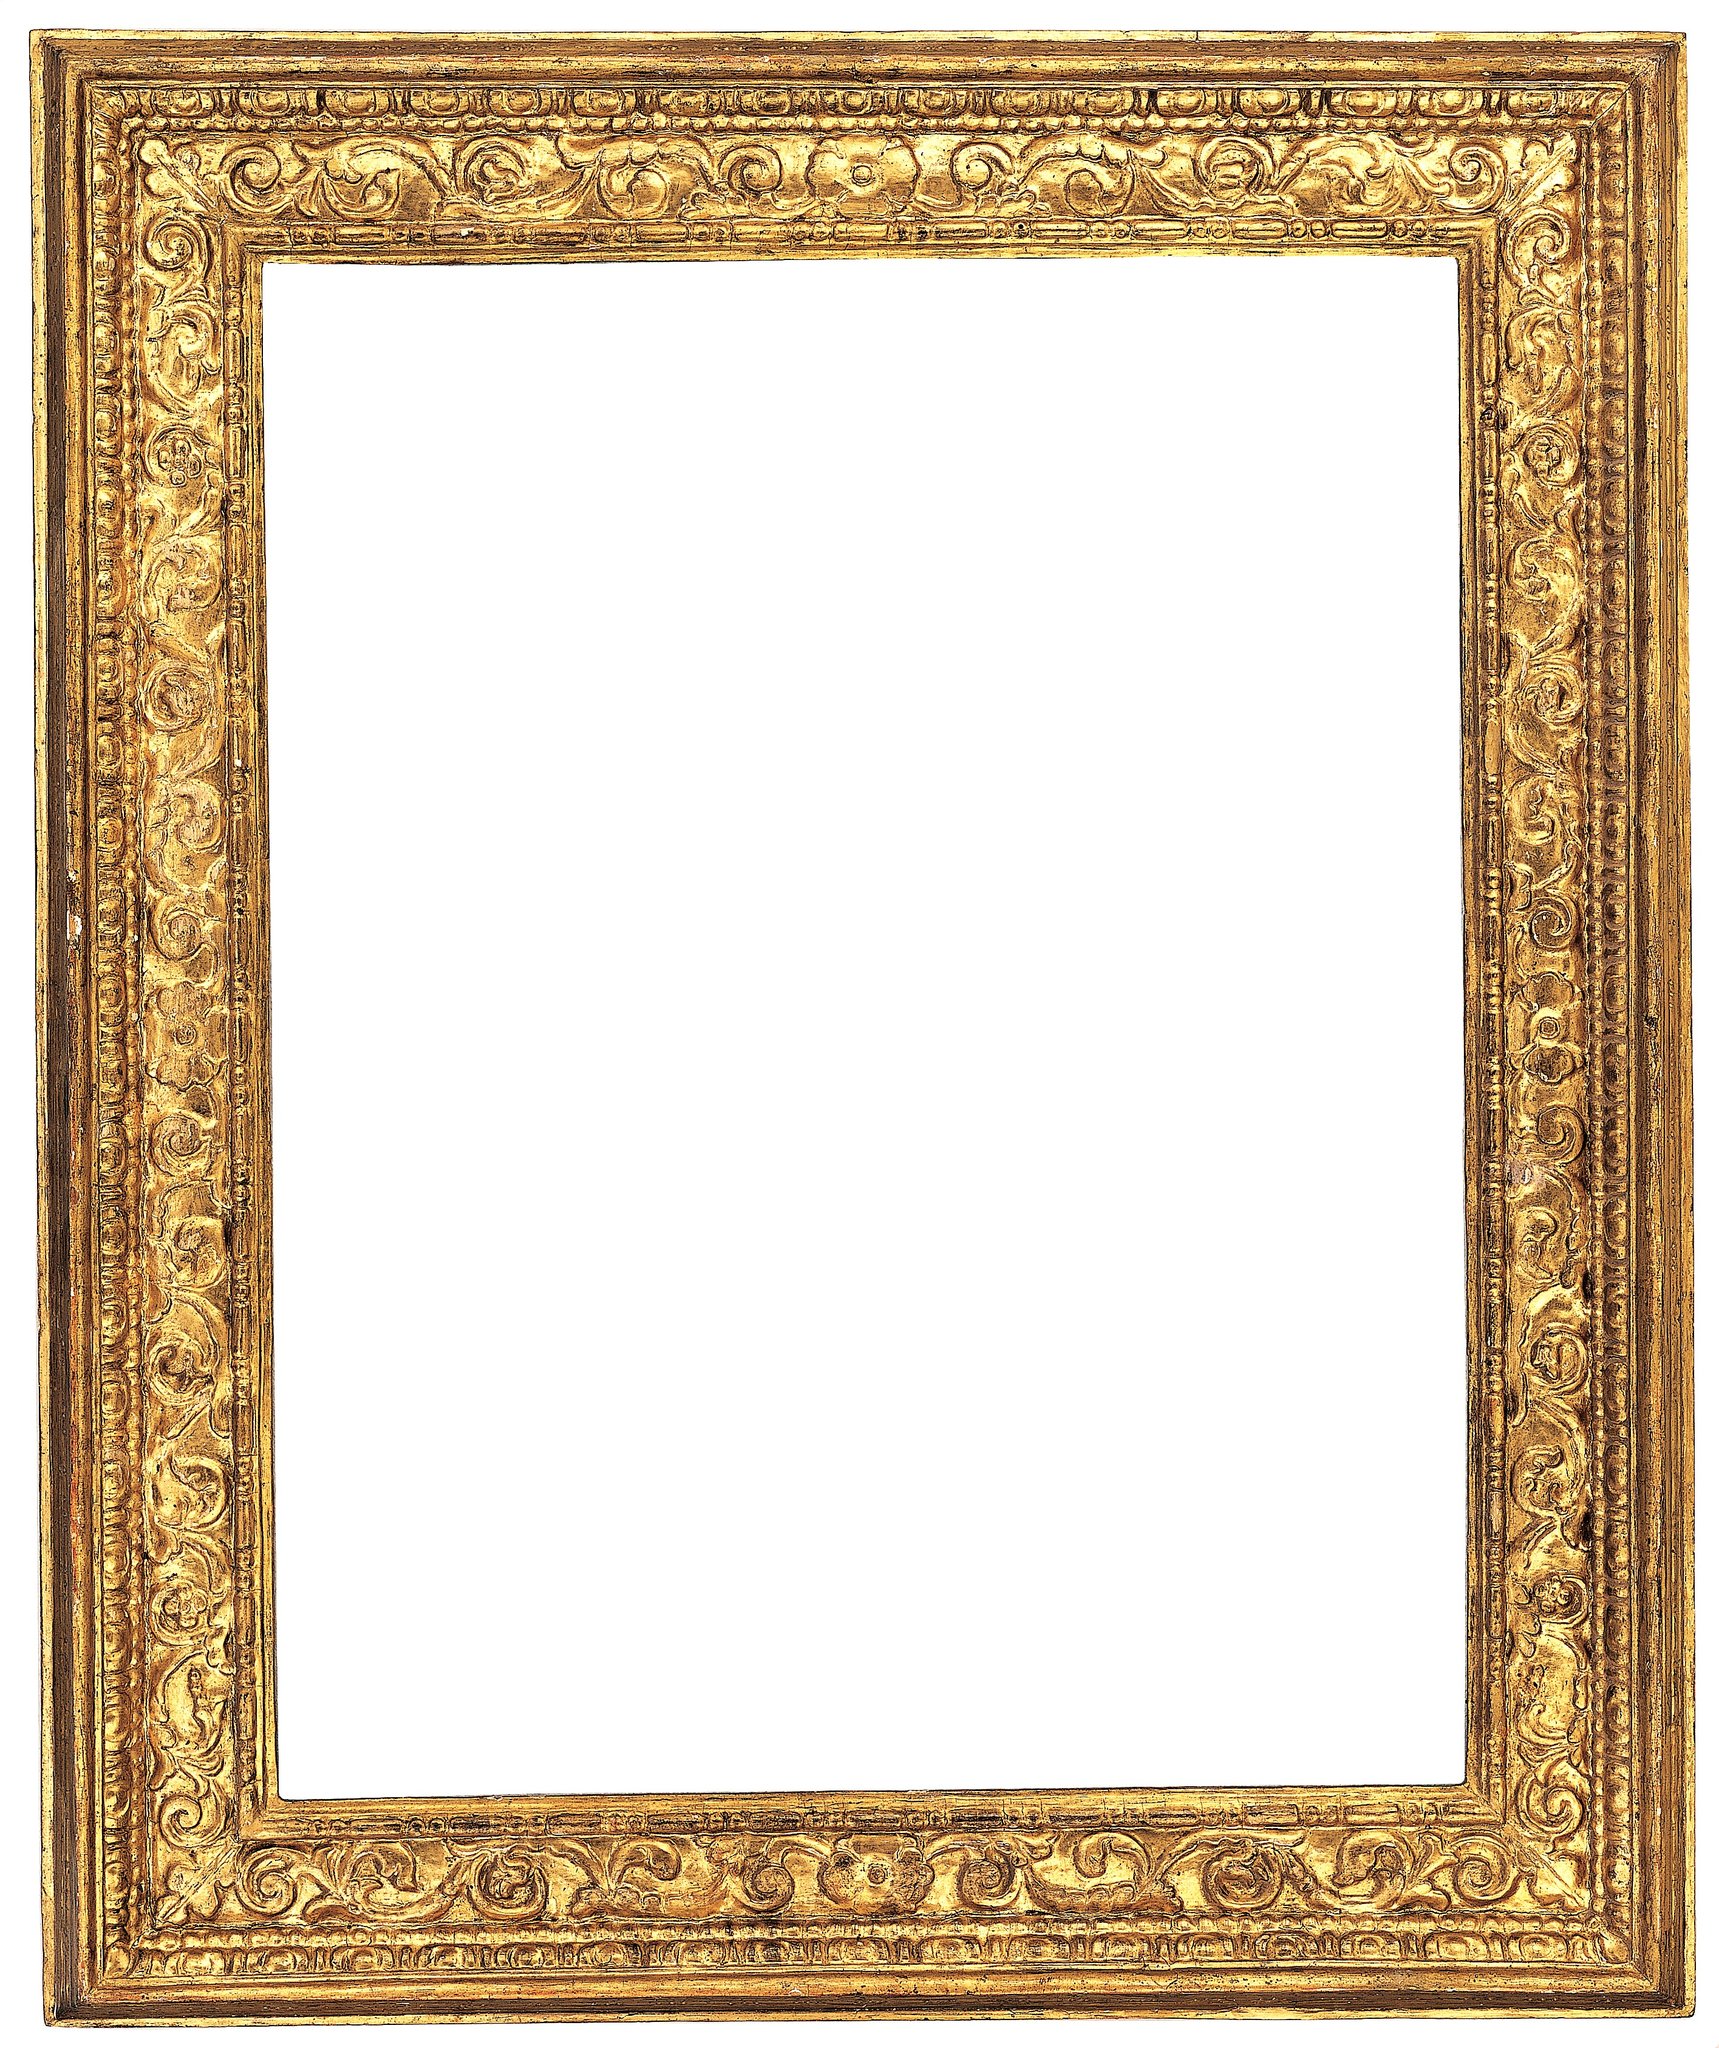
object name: frame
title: Cassetta frame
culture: italian, veneto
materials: gilt, wood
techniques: carving